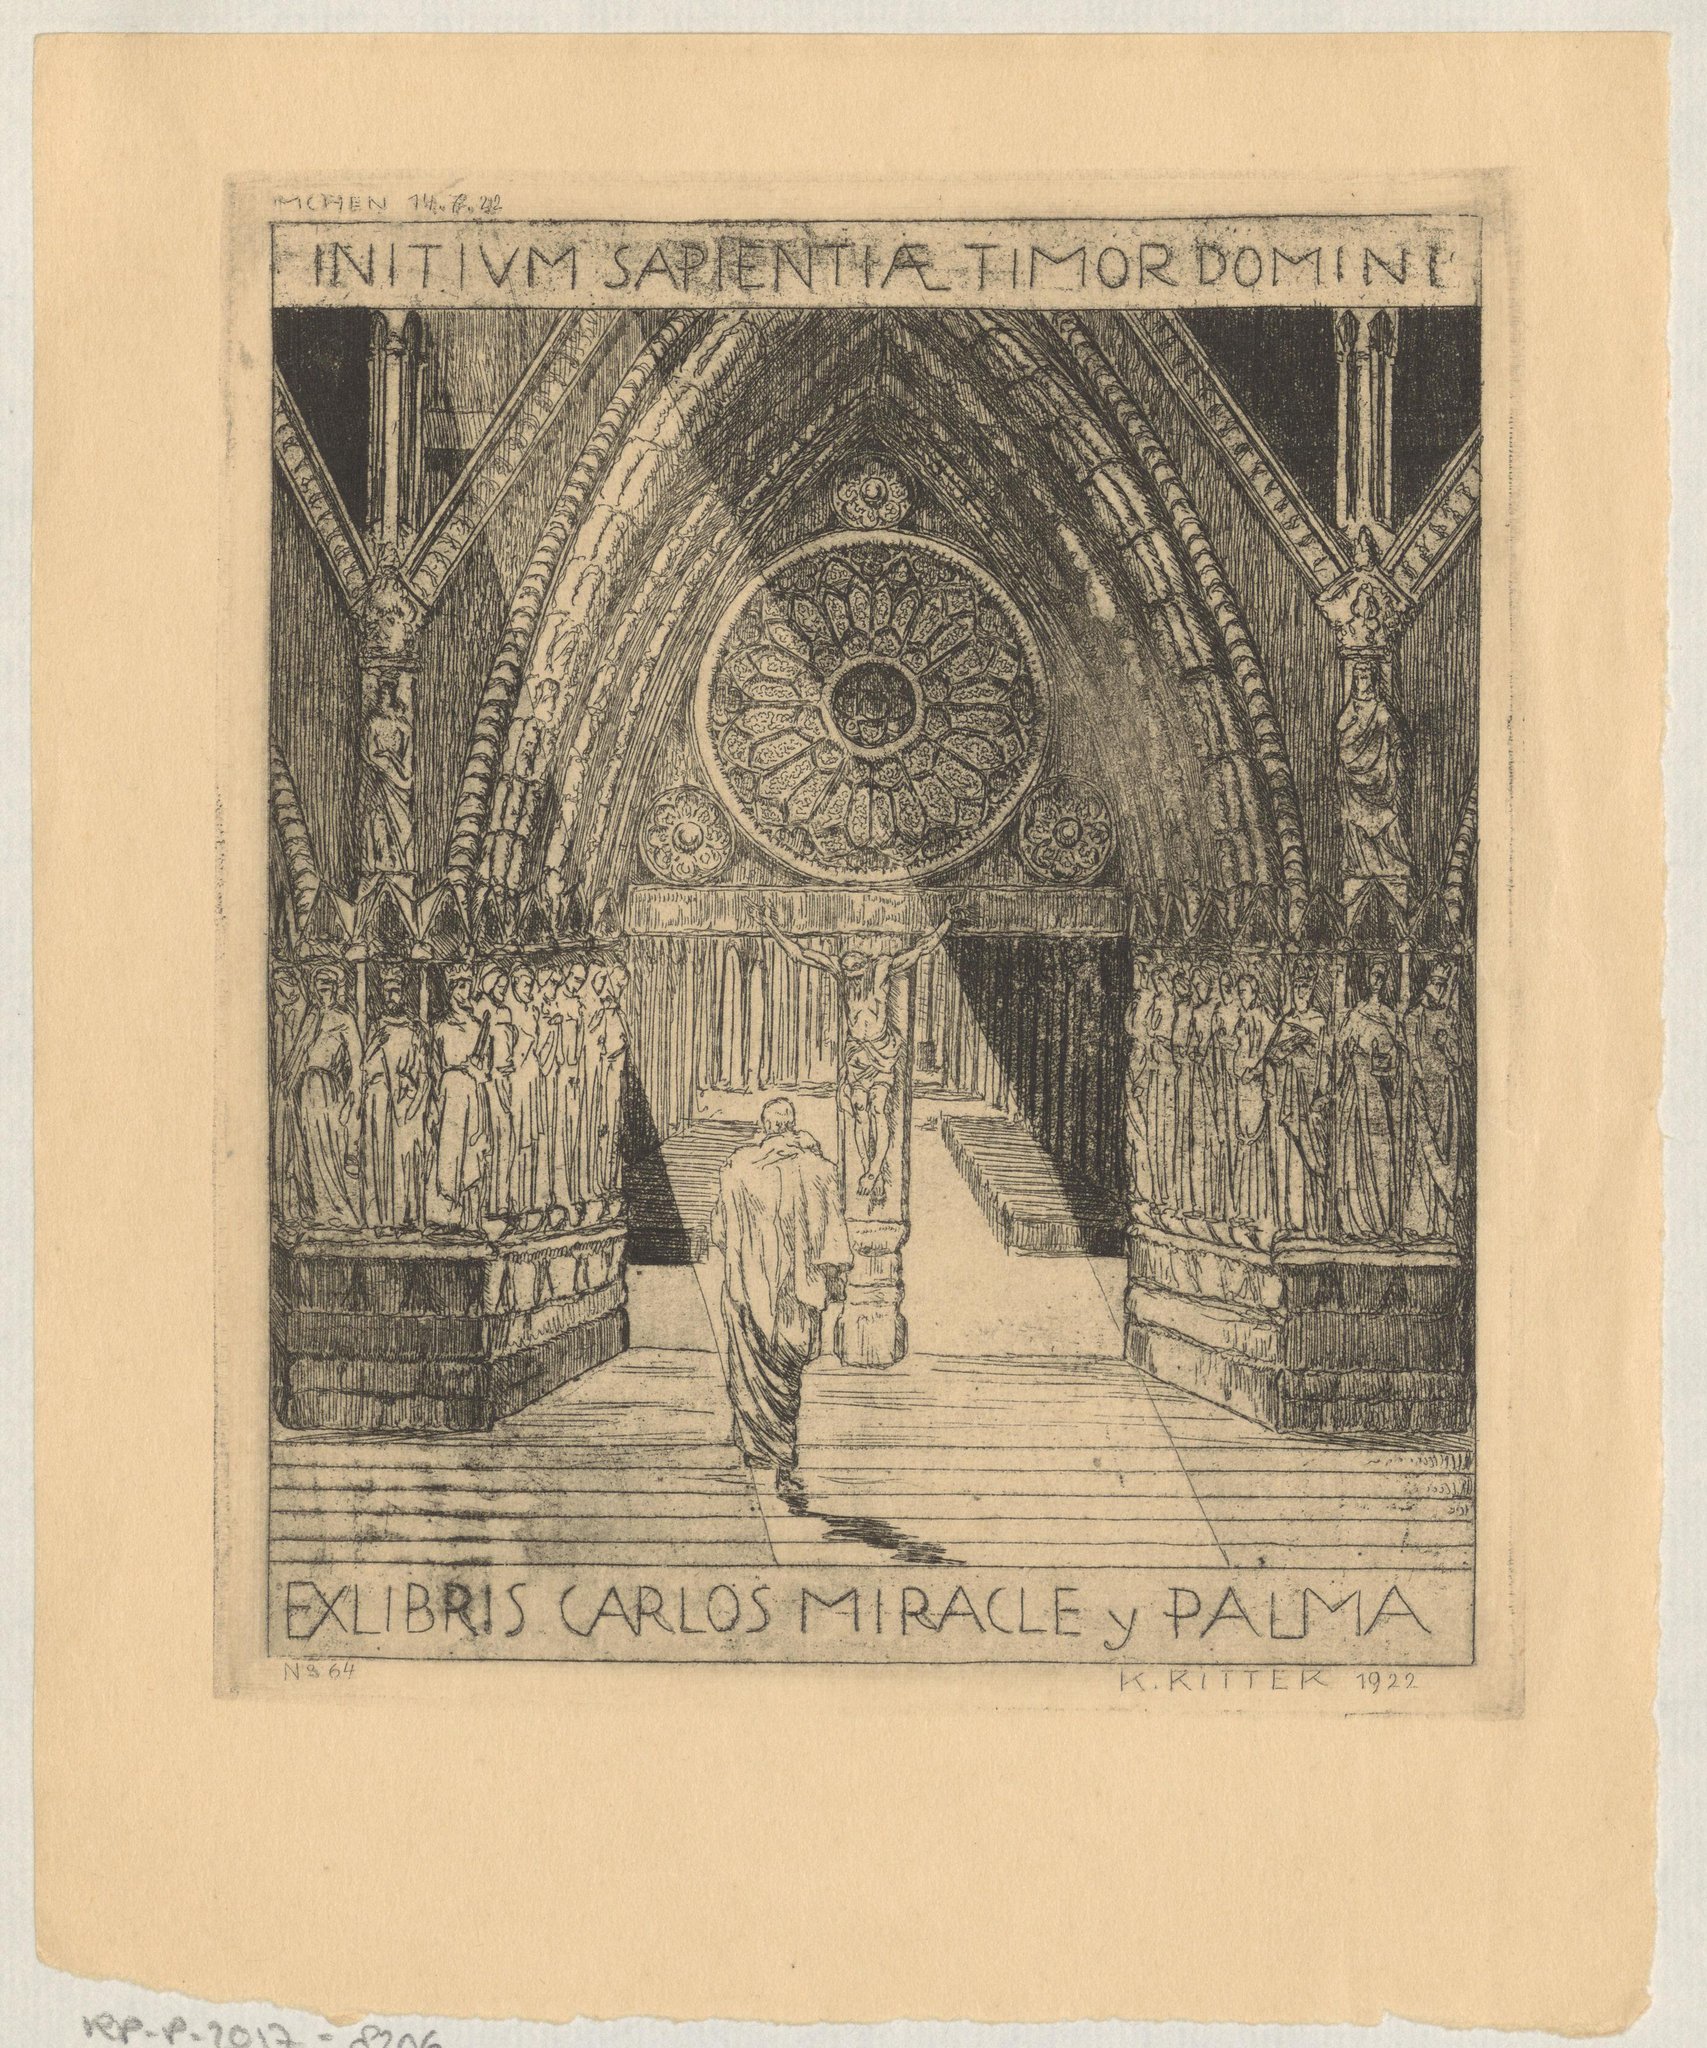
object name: bookplate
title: Ex libris van Carlos Miracle y Palma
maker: karl ritter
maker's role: print maker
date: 1922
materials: paper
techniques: aquatint, etching, intaglio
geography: spain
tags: parts of church exterior and annexes: façade, (rays of) light ~ symbol of god the father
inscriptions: date